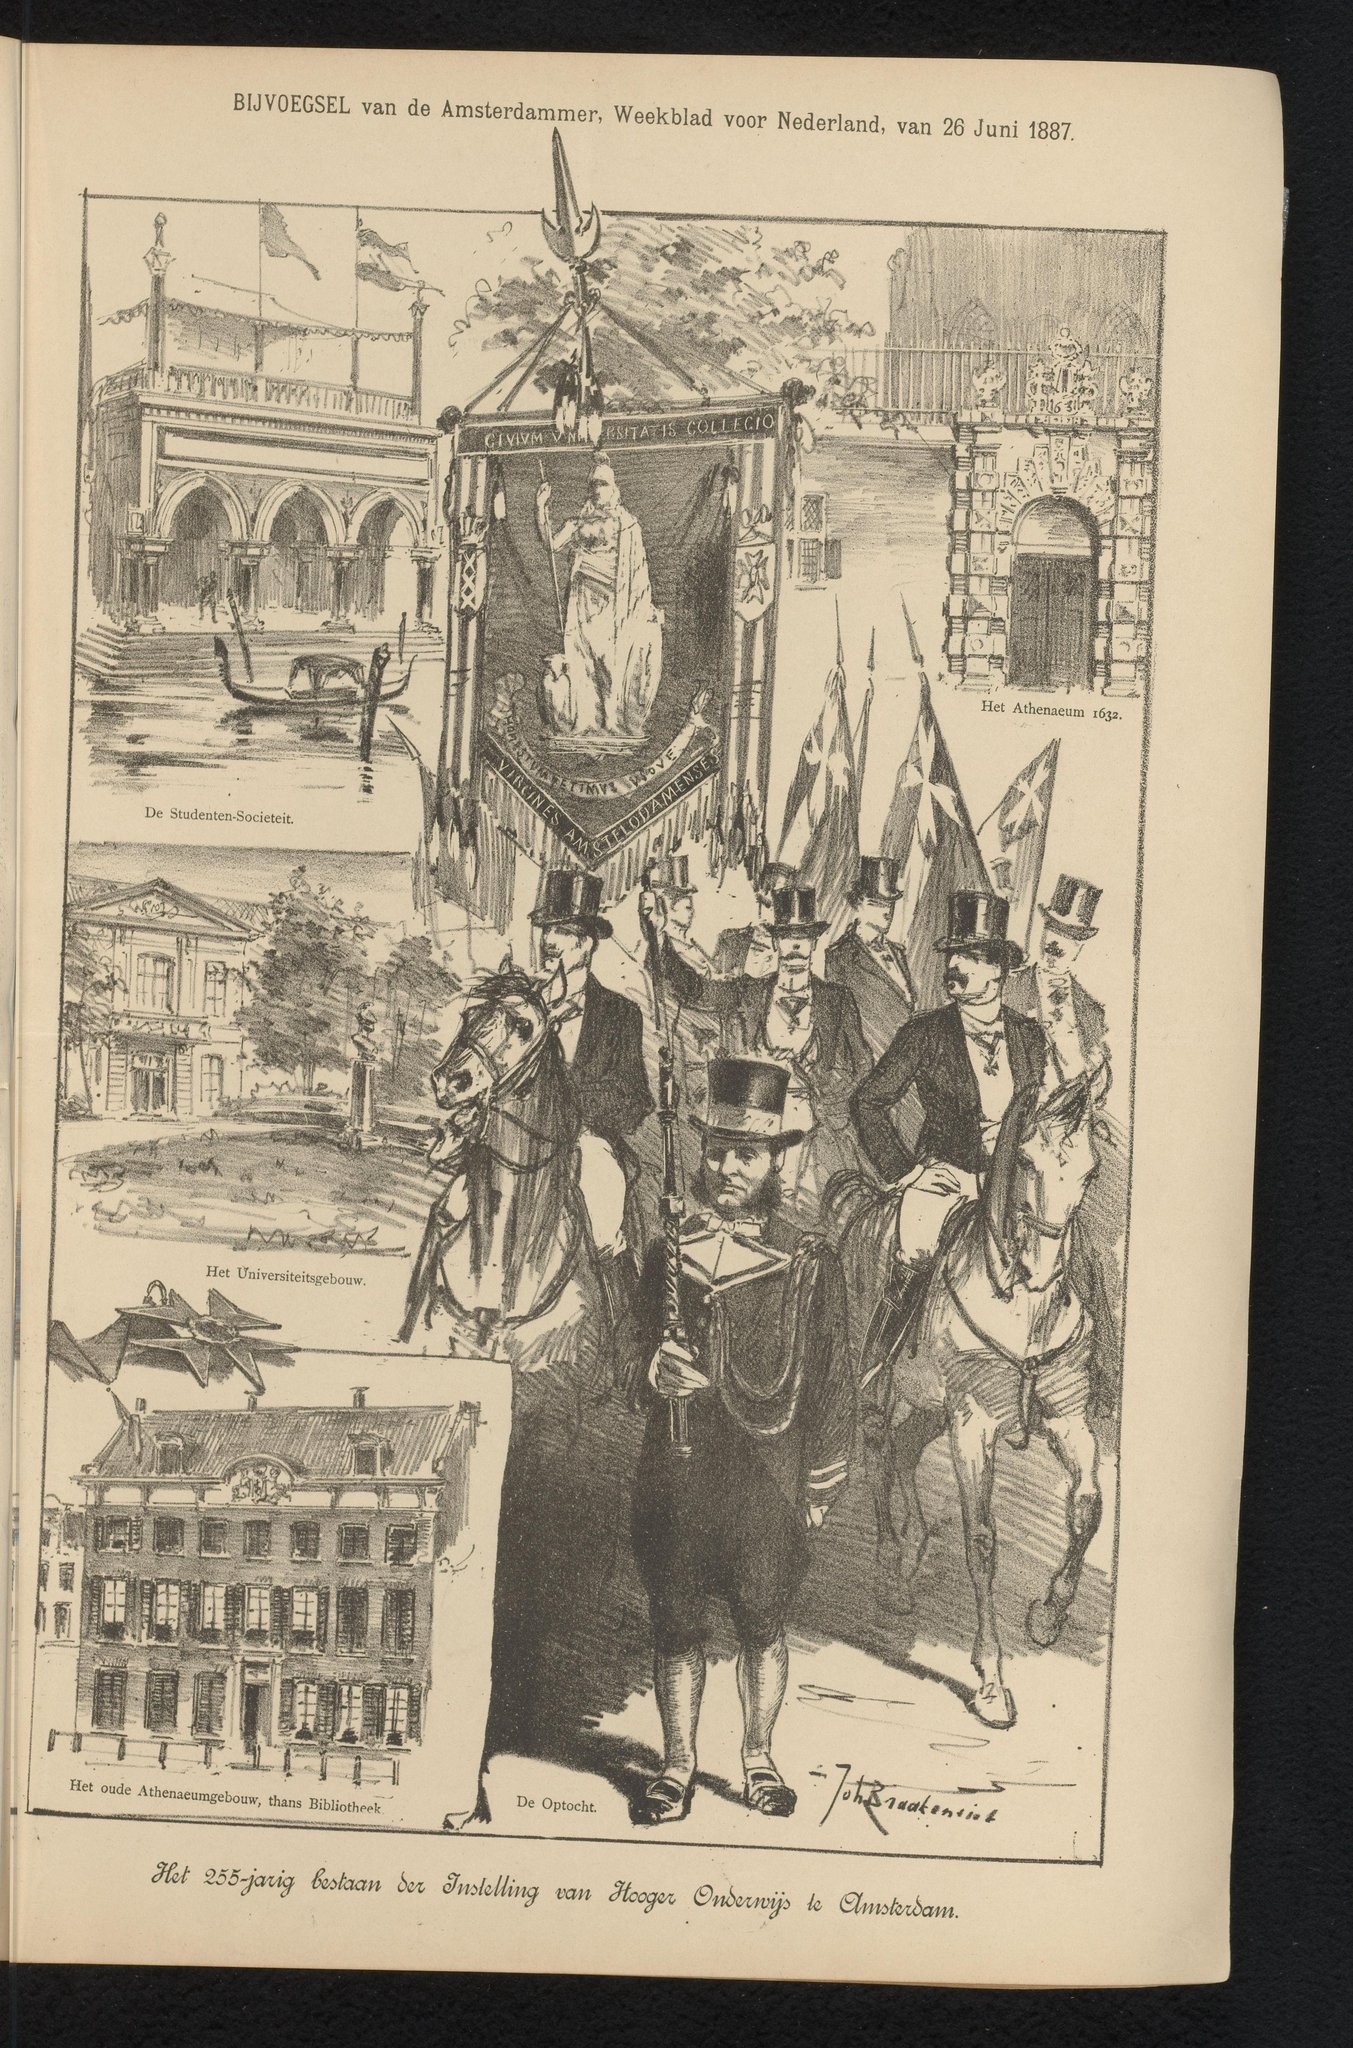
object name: print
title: Het 255-jarig bestaan der Instelling van Hooger Onderwijs te Amsterdam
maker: johan braakensiek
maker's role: draughtsman, print maker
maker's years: 1858-1940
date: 1887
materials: paper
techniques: lithograph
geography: amsterdam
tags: commemoration of the founding of a university, university, amsterdam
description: Feestelijke viering van het 255-jarig bestaan van de Universiteit van Amsterdam. Gezichten op verschillende gebouwen van de universiteit en een optocht van studenten te paard.